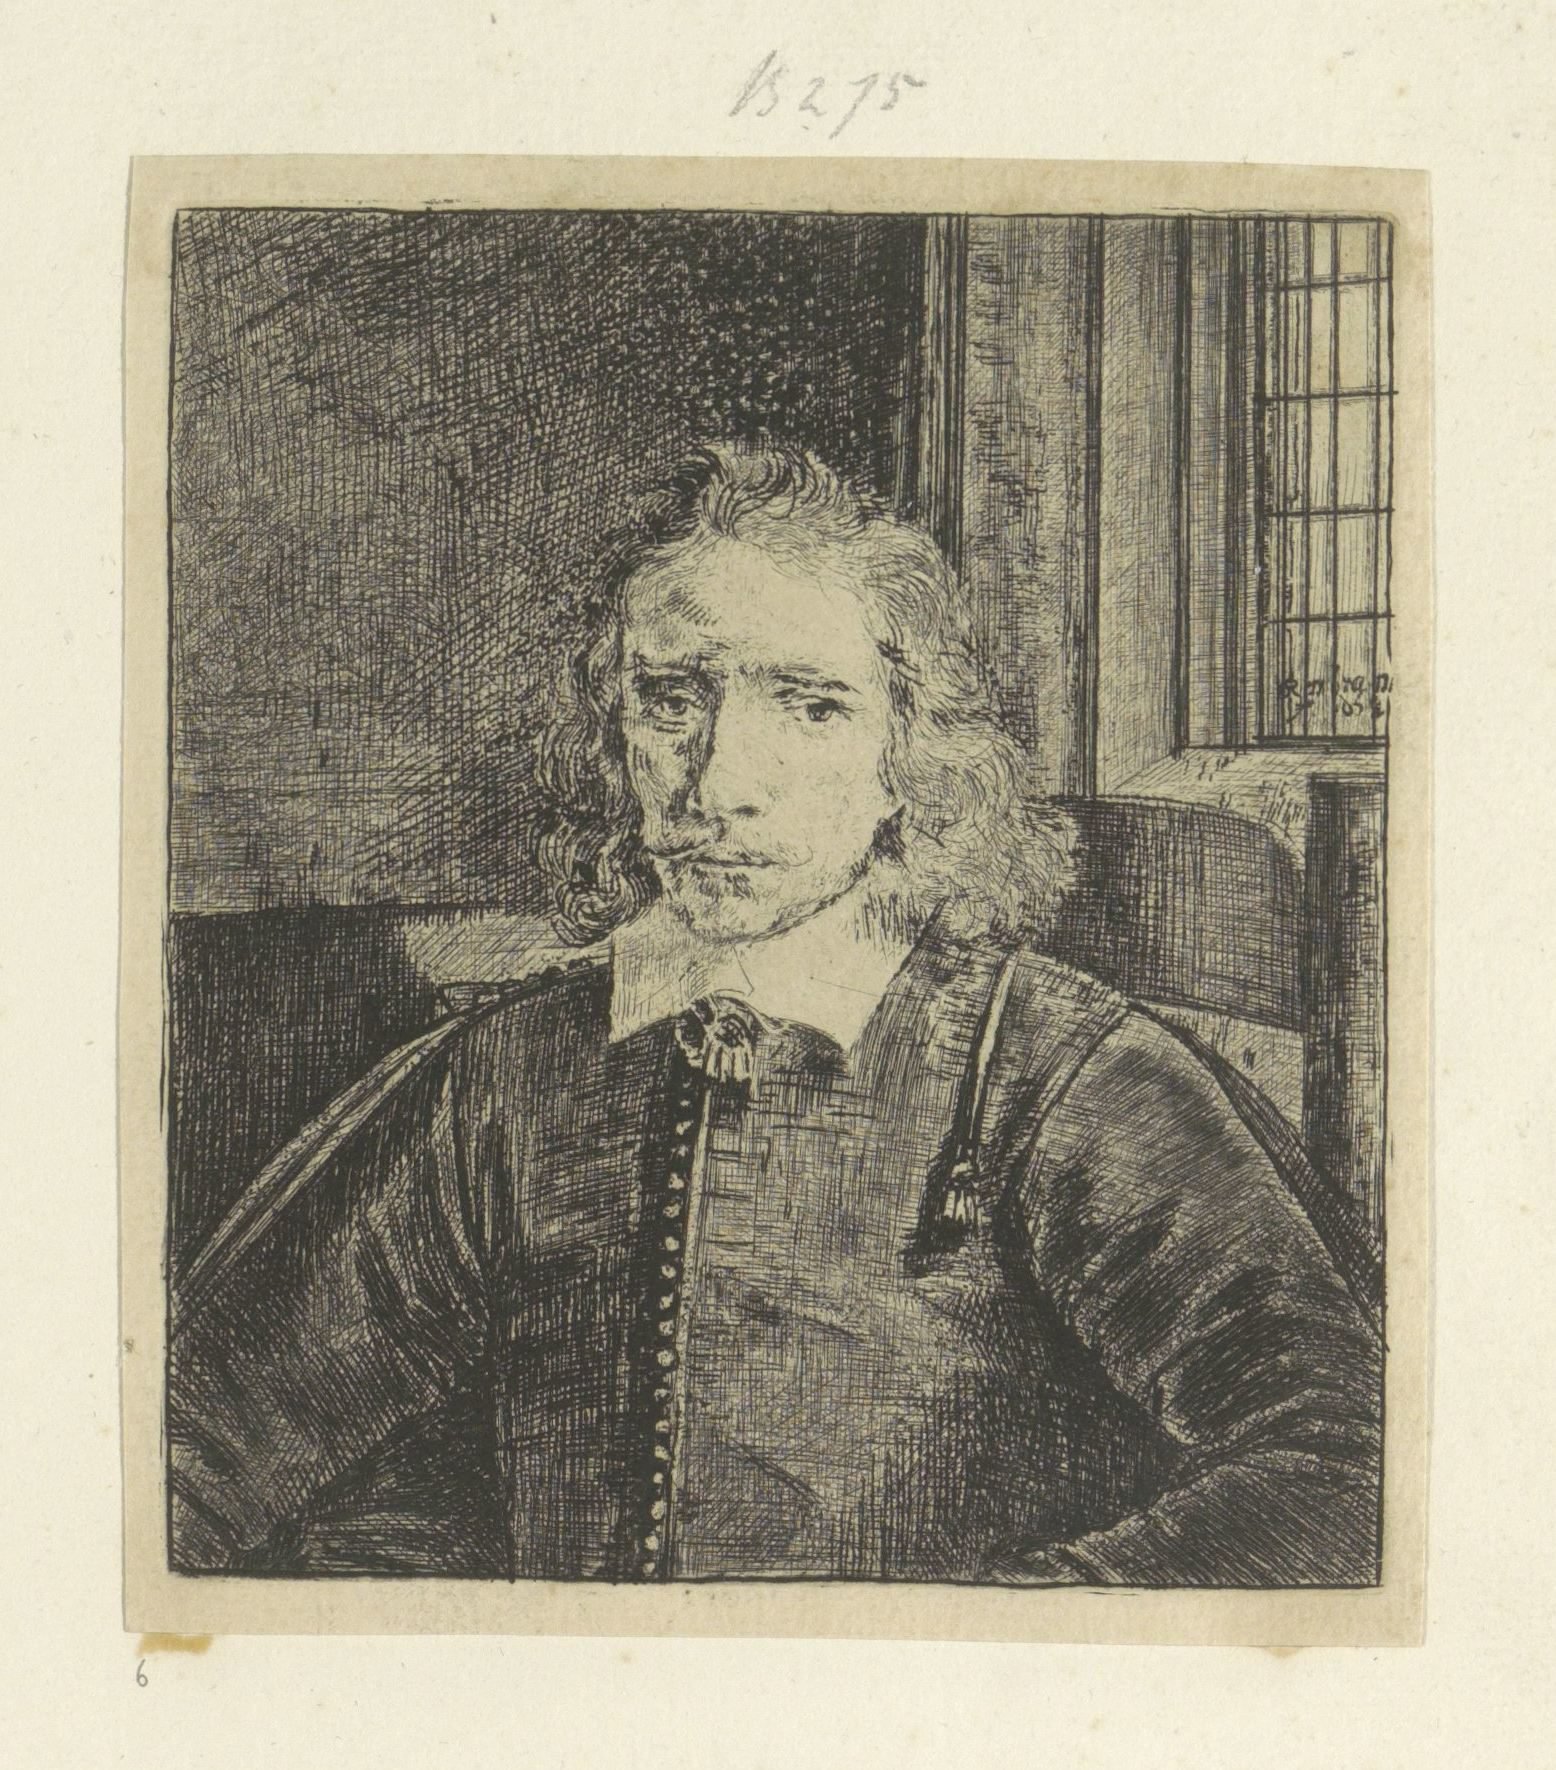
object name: print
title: Recueil de quatre-vingt-cinq estampes originales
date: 1655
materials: paper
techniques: drypoint, etching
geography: paris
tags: pieter haringh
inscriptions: date